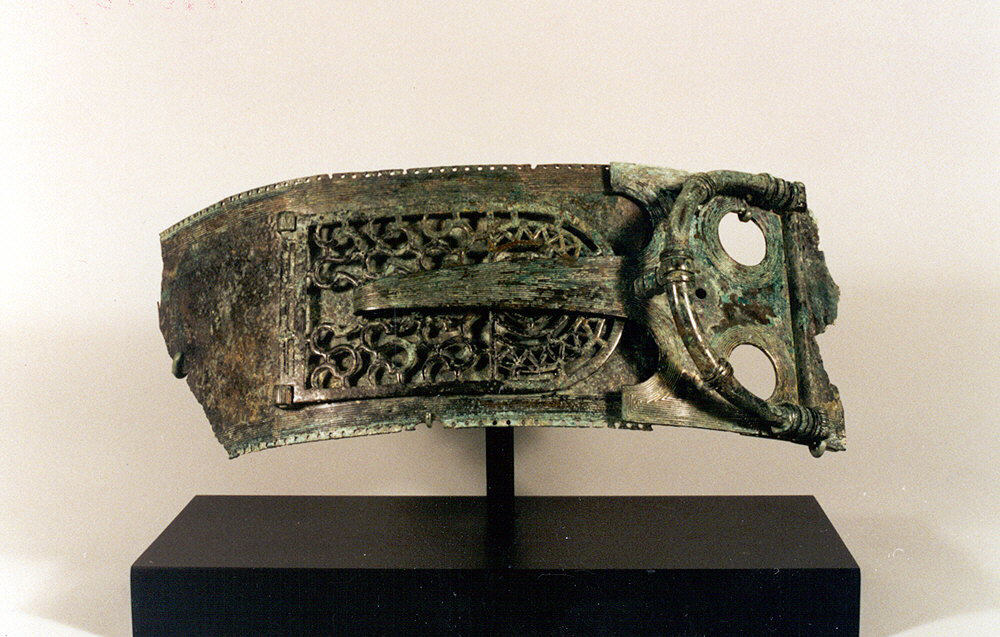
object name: belt buckle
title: Belt fragment with a buckle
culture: phrygian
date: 800-601 BCE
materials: bronze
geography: phrygia